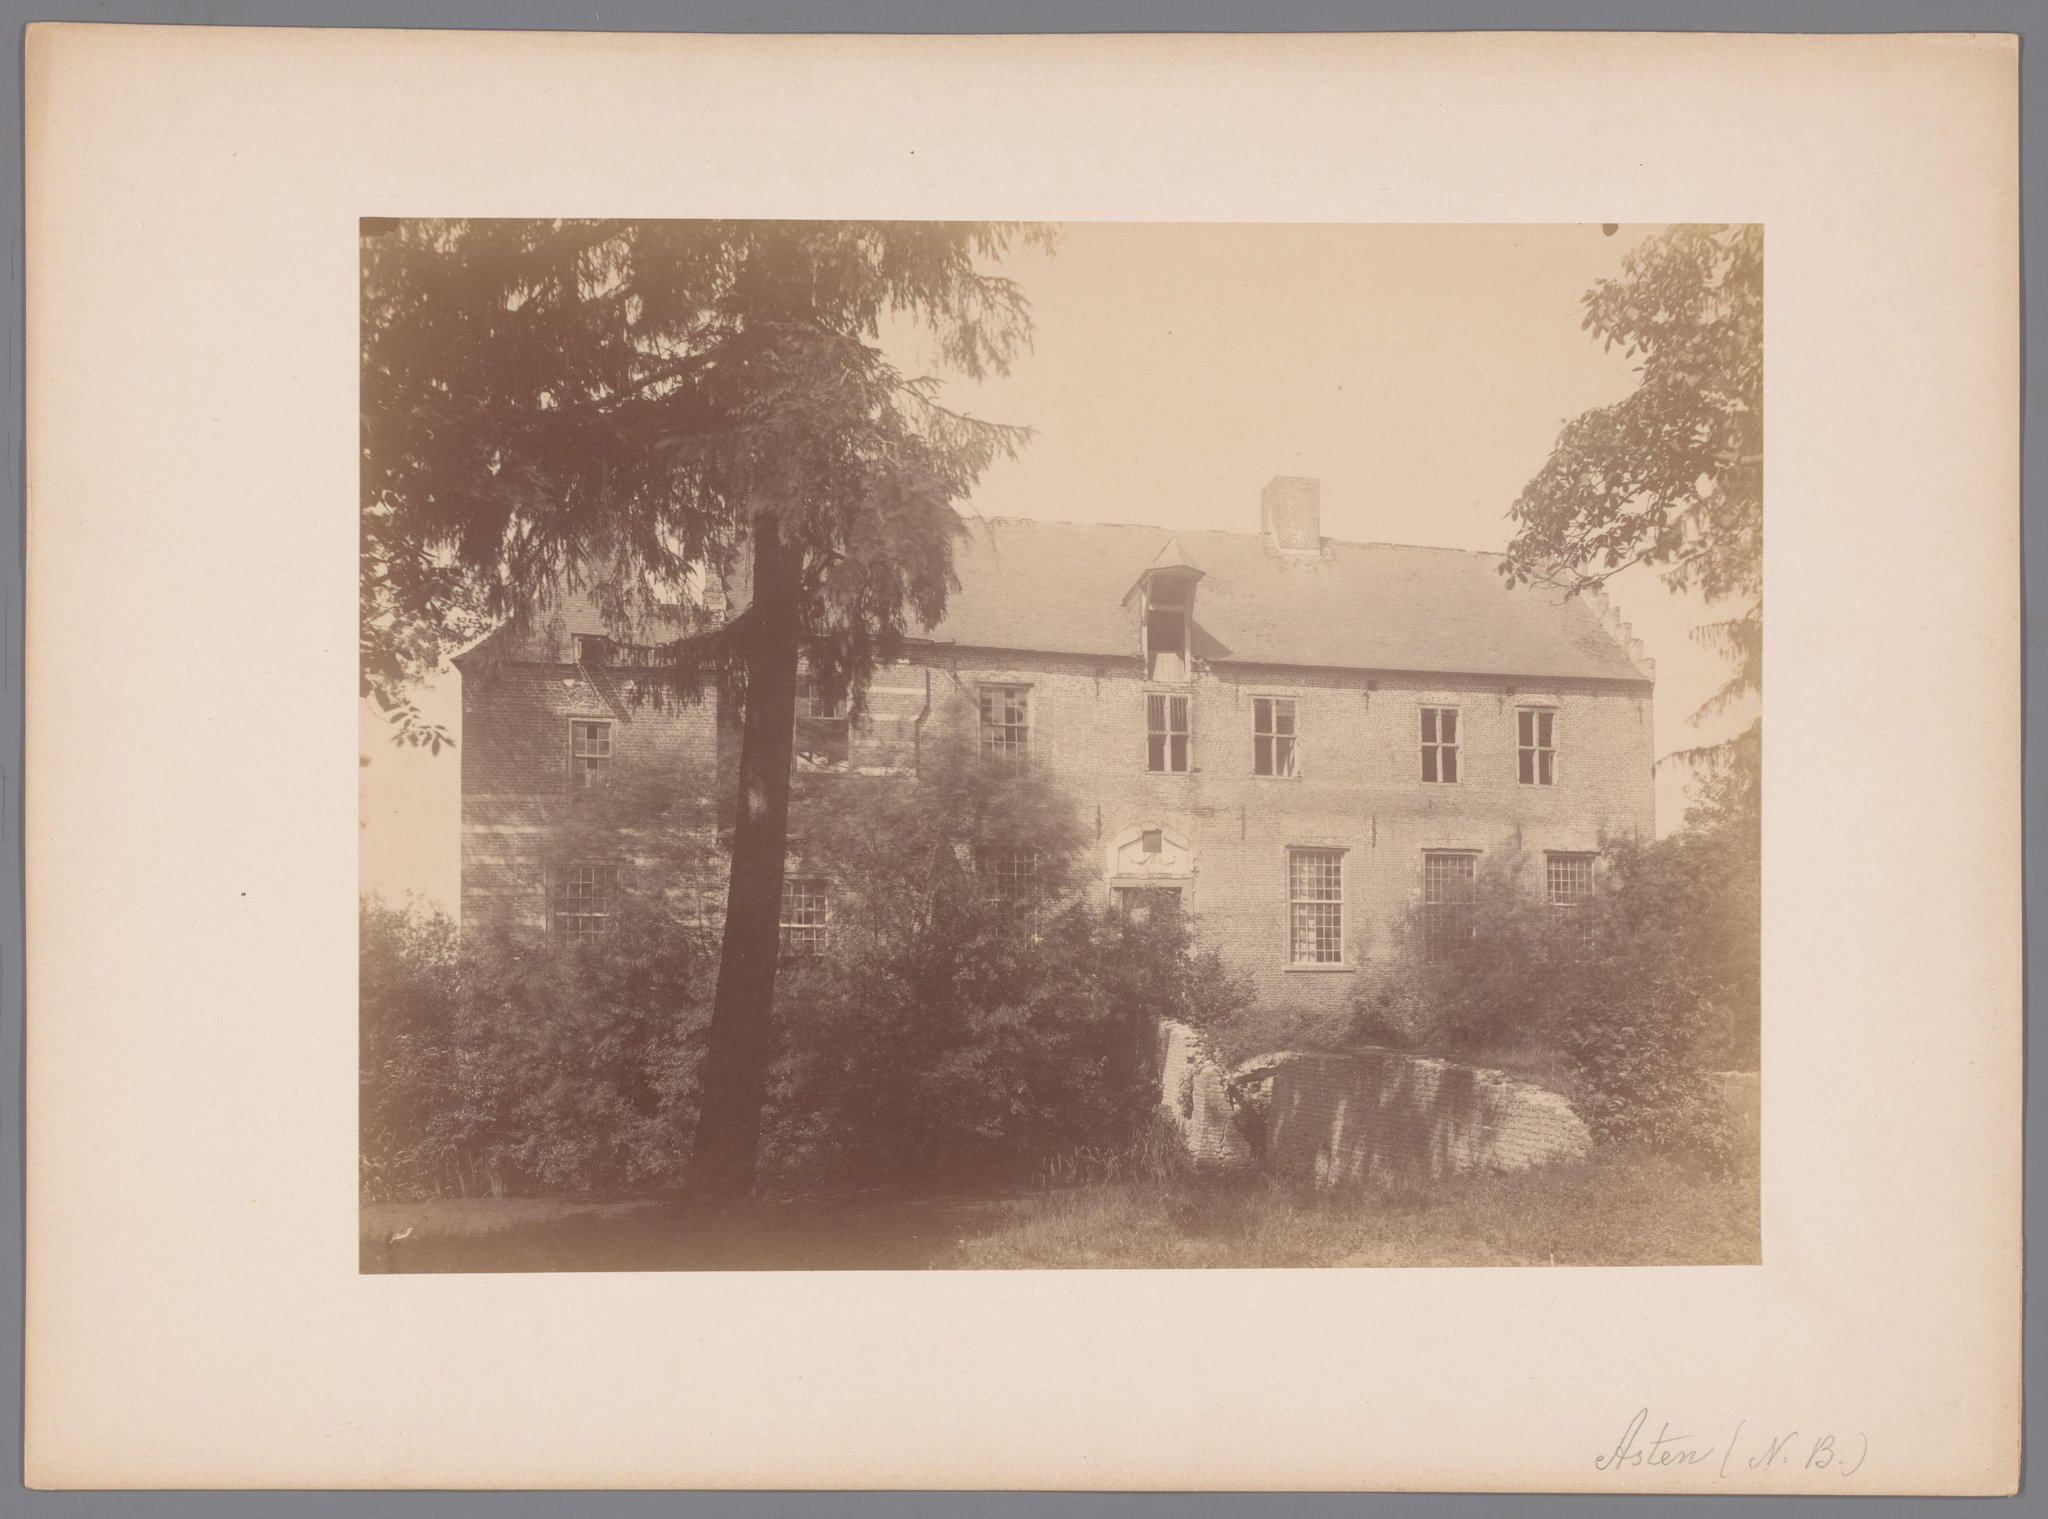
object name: photograph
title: Gezicht op de kasteelruïne van Asten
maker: anoniem (monumentenzorg)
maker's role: fotograaf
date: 1890-1920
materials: cardboard, photographic support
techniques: albumen print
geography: asten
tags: castle, ruin of a dwelling, house, castle, etc.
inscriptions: annotation: ‘Asten (N.B.)’, annotation: ‘Kasteel (ruine) te Asten N.B.’